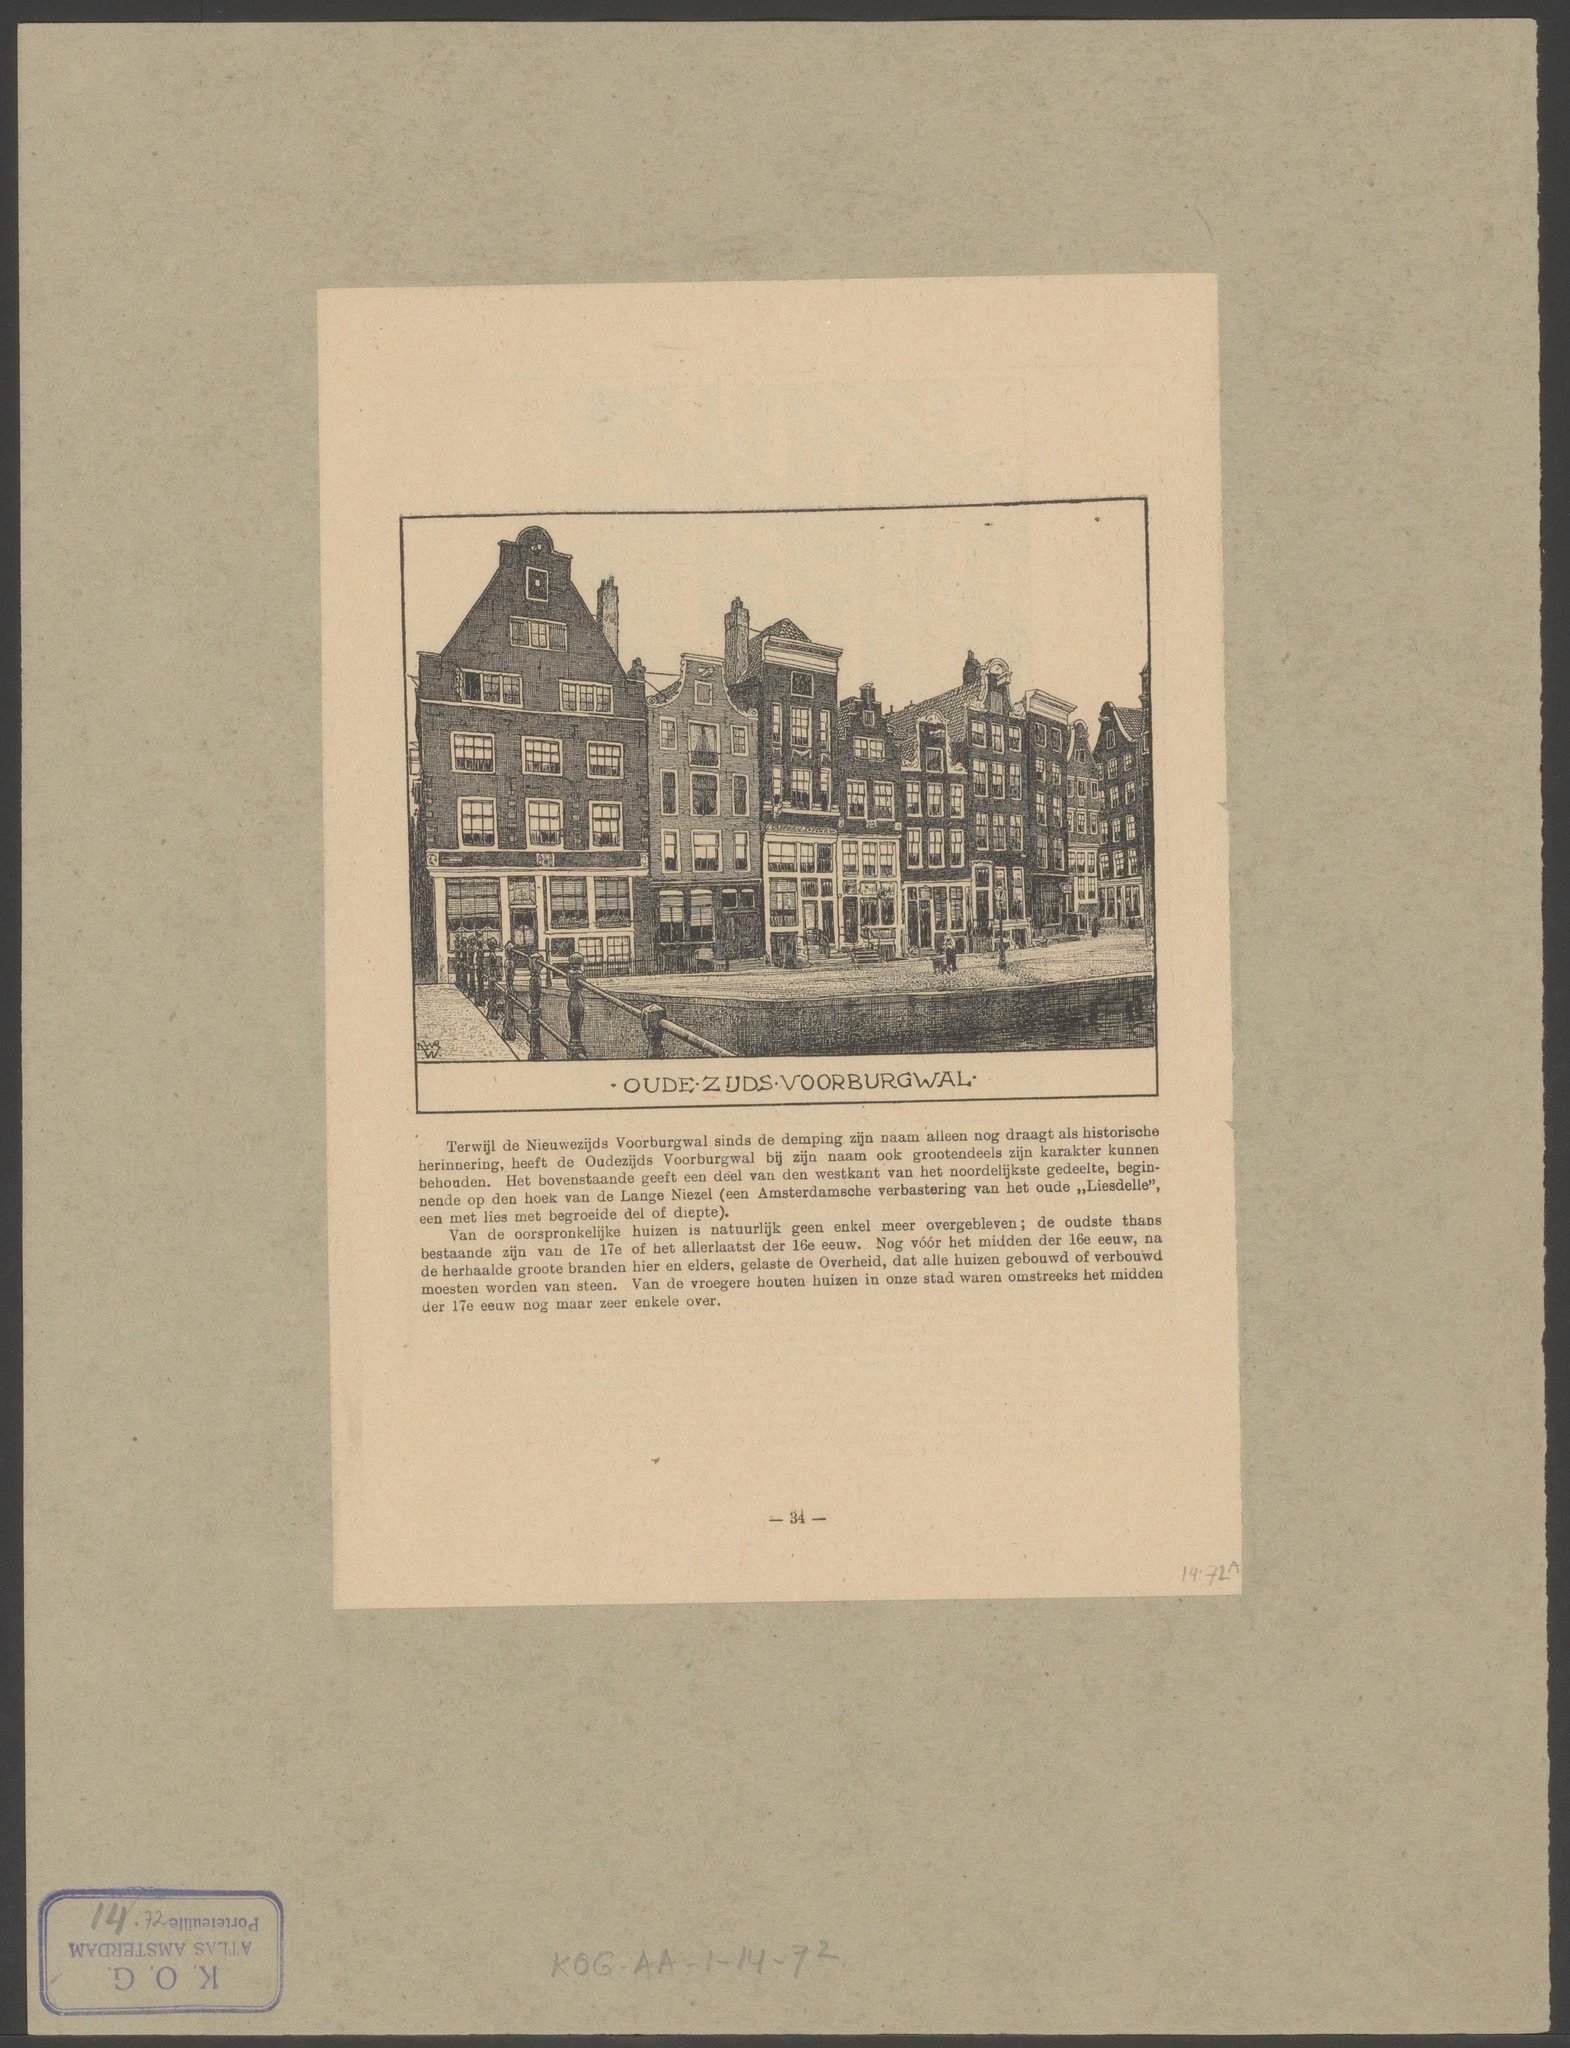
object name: photomechanical print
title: Oud-Amsterdam 100 Stadsgezichten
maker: willem wenckebach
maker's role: designer, draughtsman, painter, print maker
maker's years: 1860-1937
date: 1870-1923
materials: paper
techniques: letterpress printing, line block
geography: amsterdam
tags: city-view in general; 'veduta', canal, the usual house or row of houses, street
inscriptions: collector's mark: ‘14.72’ Lugt 1641b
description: Fotomechanische afdruk uit een editie van Het Nieuws van den Dag, mogelijk uit de serie: Oud-Amsterdam 100 Stadsgezichten.